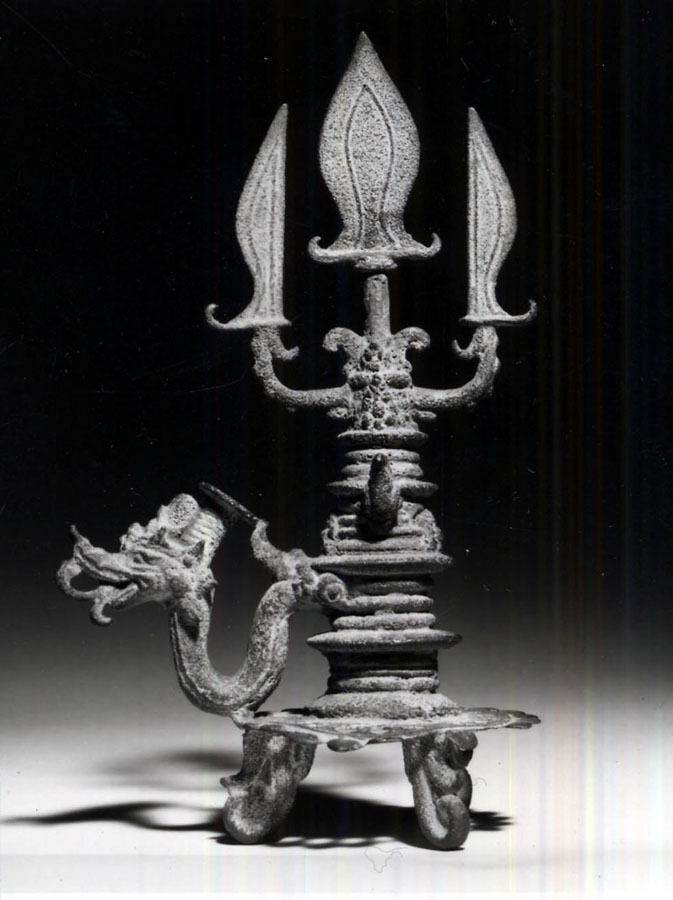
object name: figure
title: Miniature Trident with Naga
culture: indonesian, javanese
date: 1001-1200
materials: bronze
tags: snakes